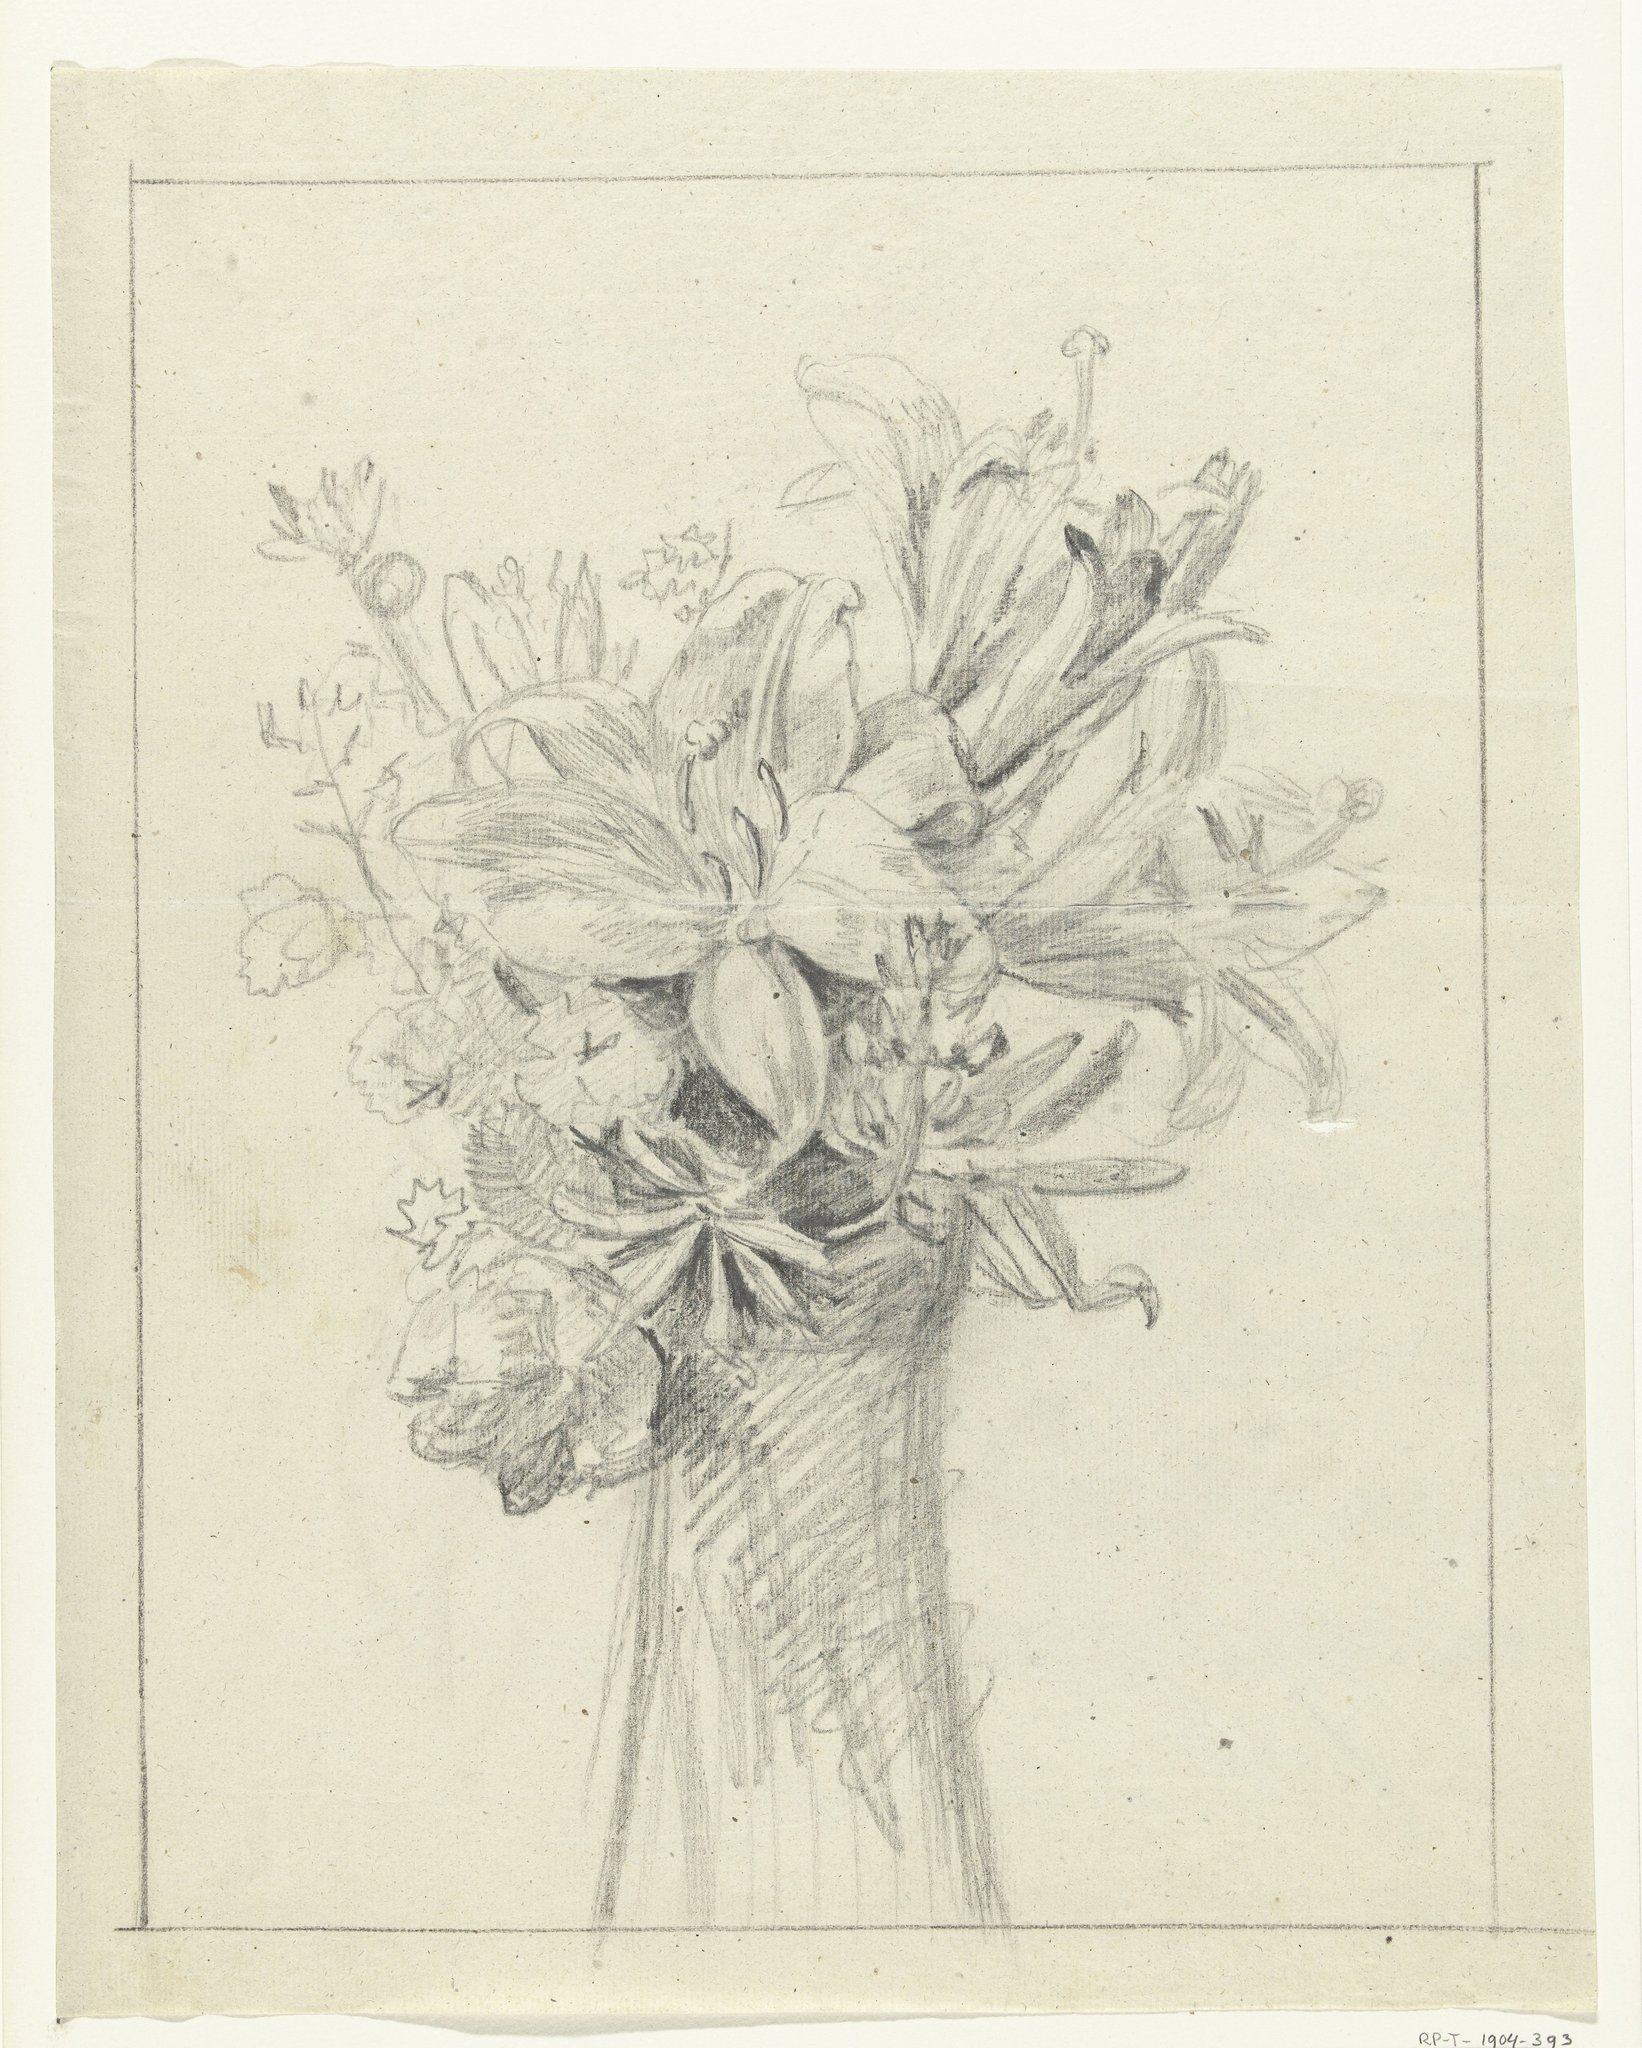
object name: drawing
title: Bloemen in een vaas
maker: jean bernard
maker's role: draughtsman, print maker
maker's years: 1765-1833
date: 1775-1833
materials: chalk, paper, pencil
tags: cut flowers; nosegay, bunch of flowers, flowers in a vase